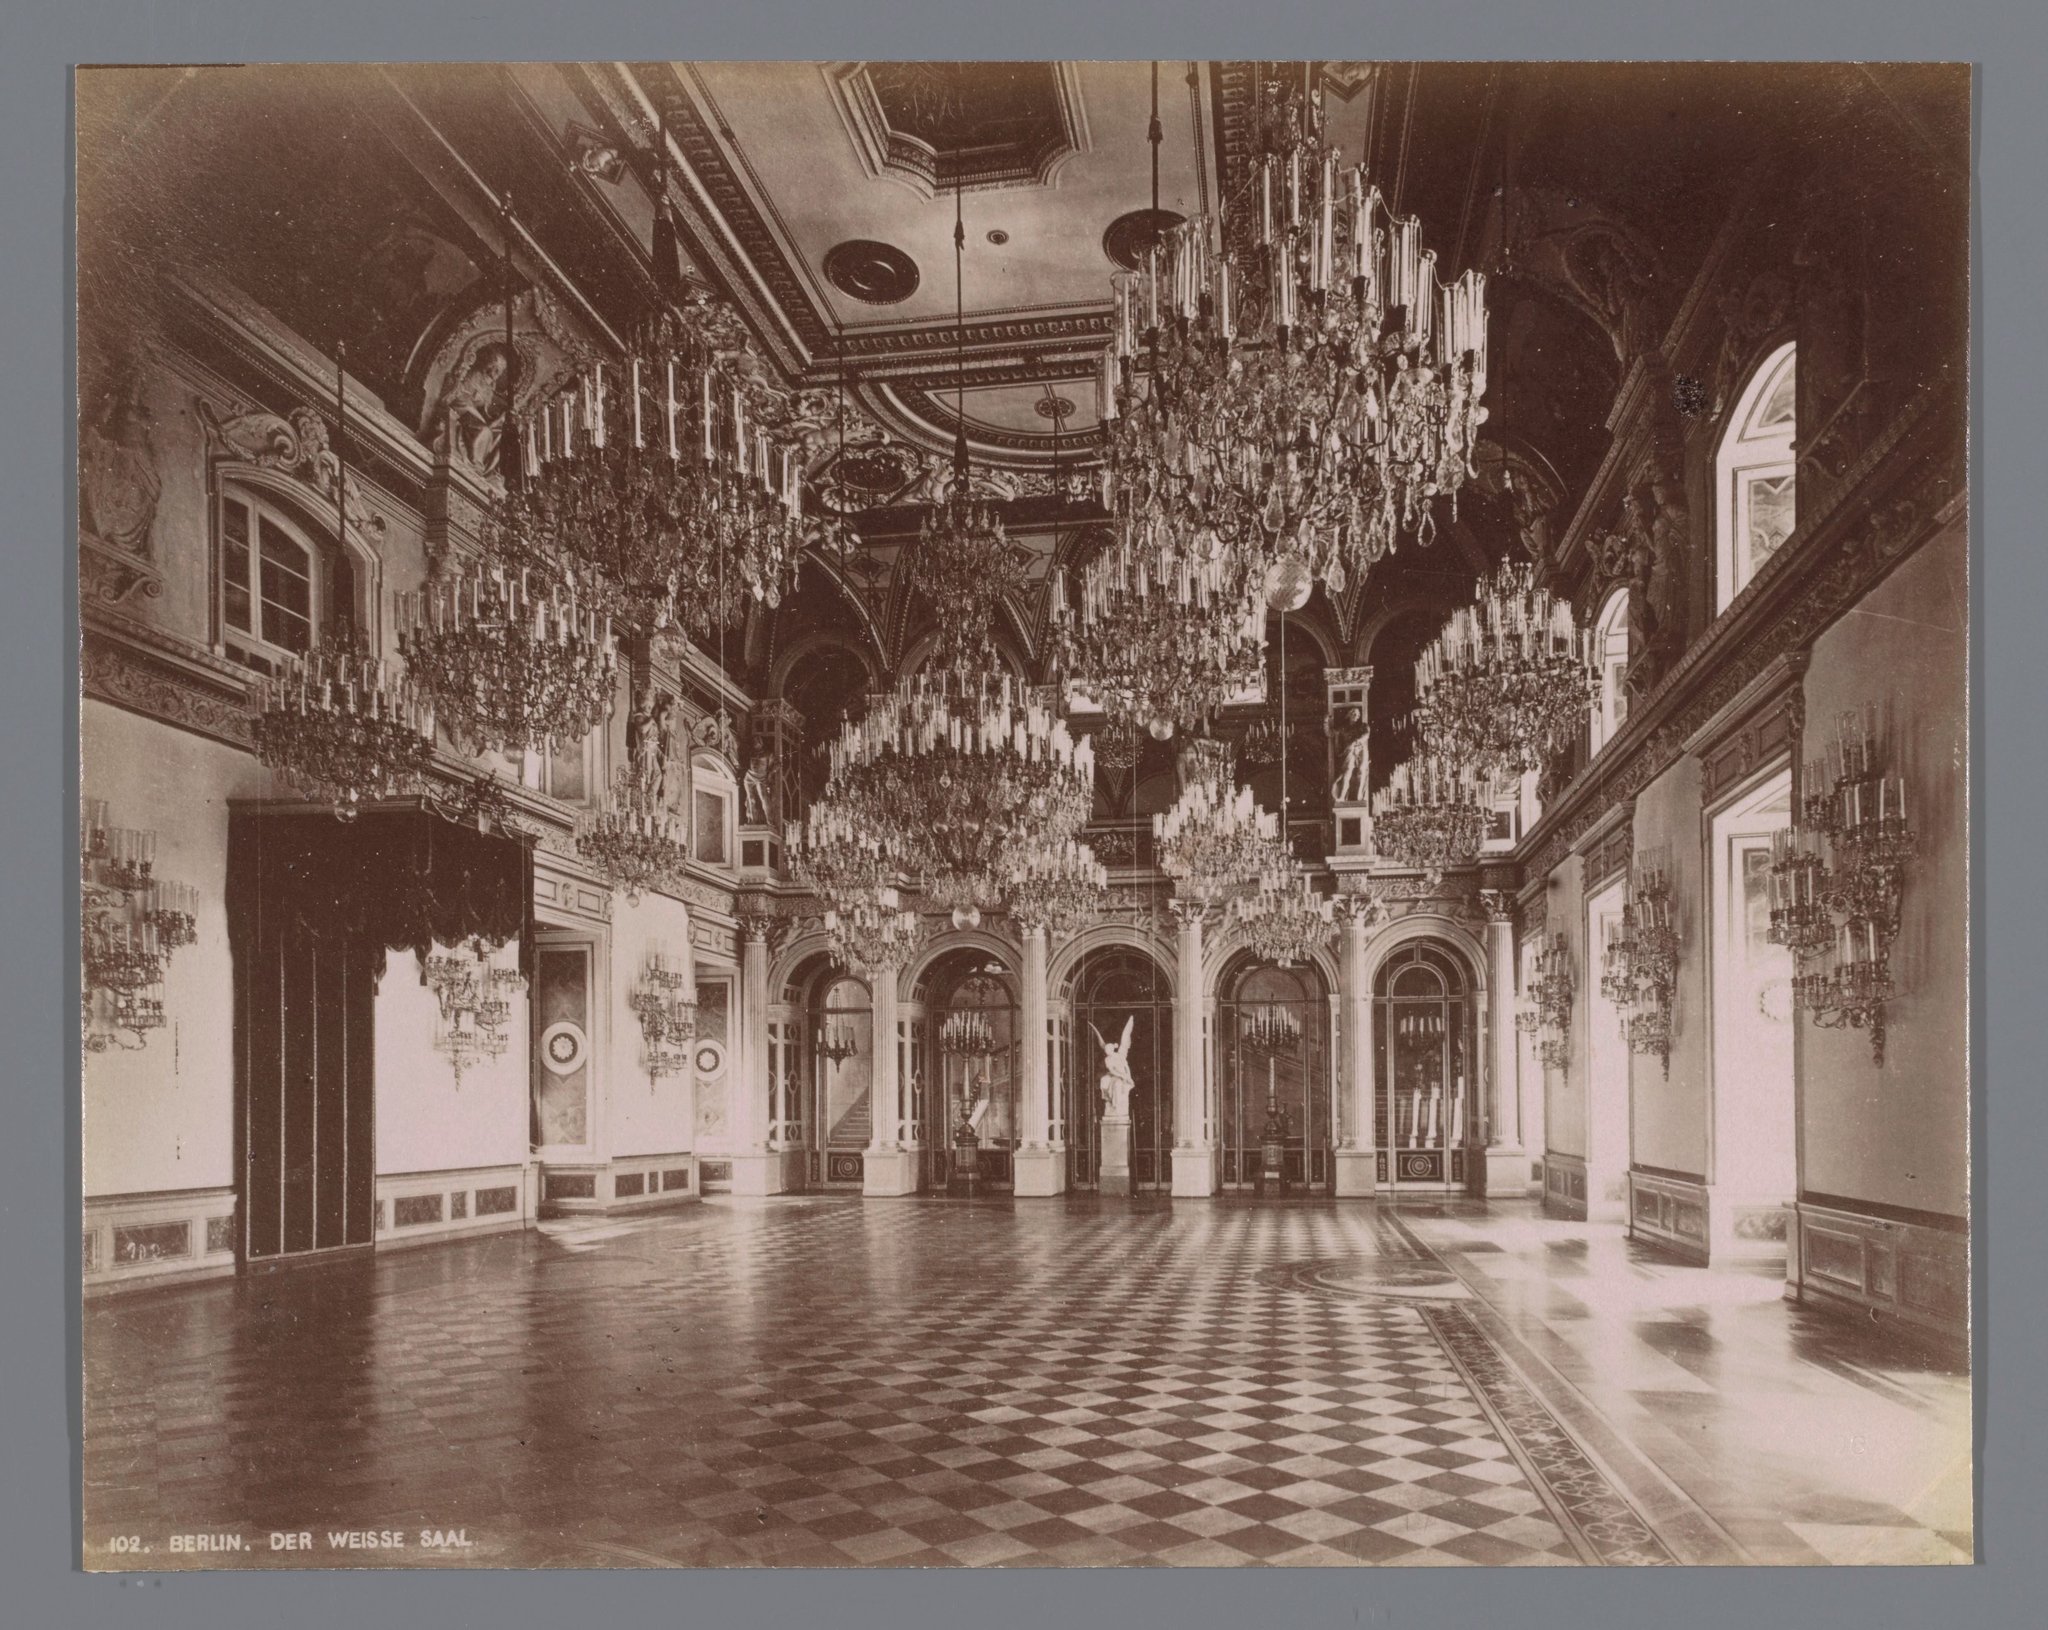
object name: photograph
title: Berlin, der Weisse Saal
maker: Anonymous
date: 1892-1910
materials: paper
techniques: albumen print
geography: berlin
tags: palace - aa - civic architecture: inside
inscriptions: inscription: ‘102. Berlin. Der weisse Saal’